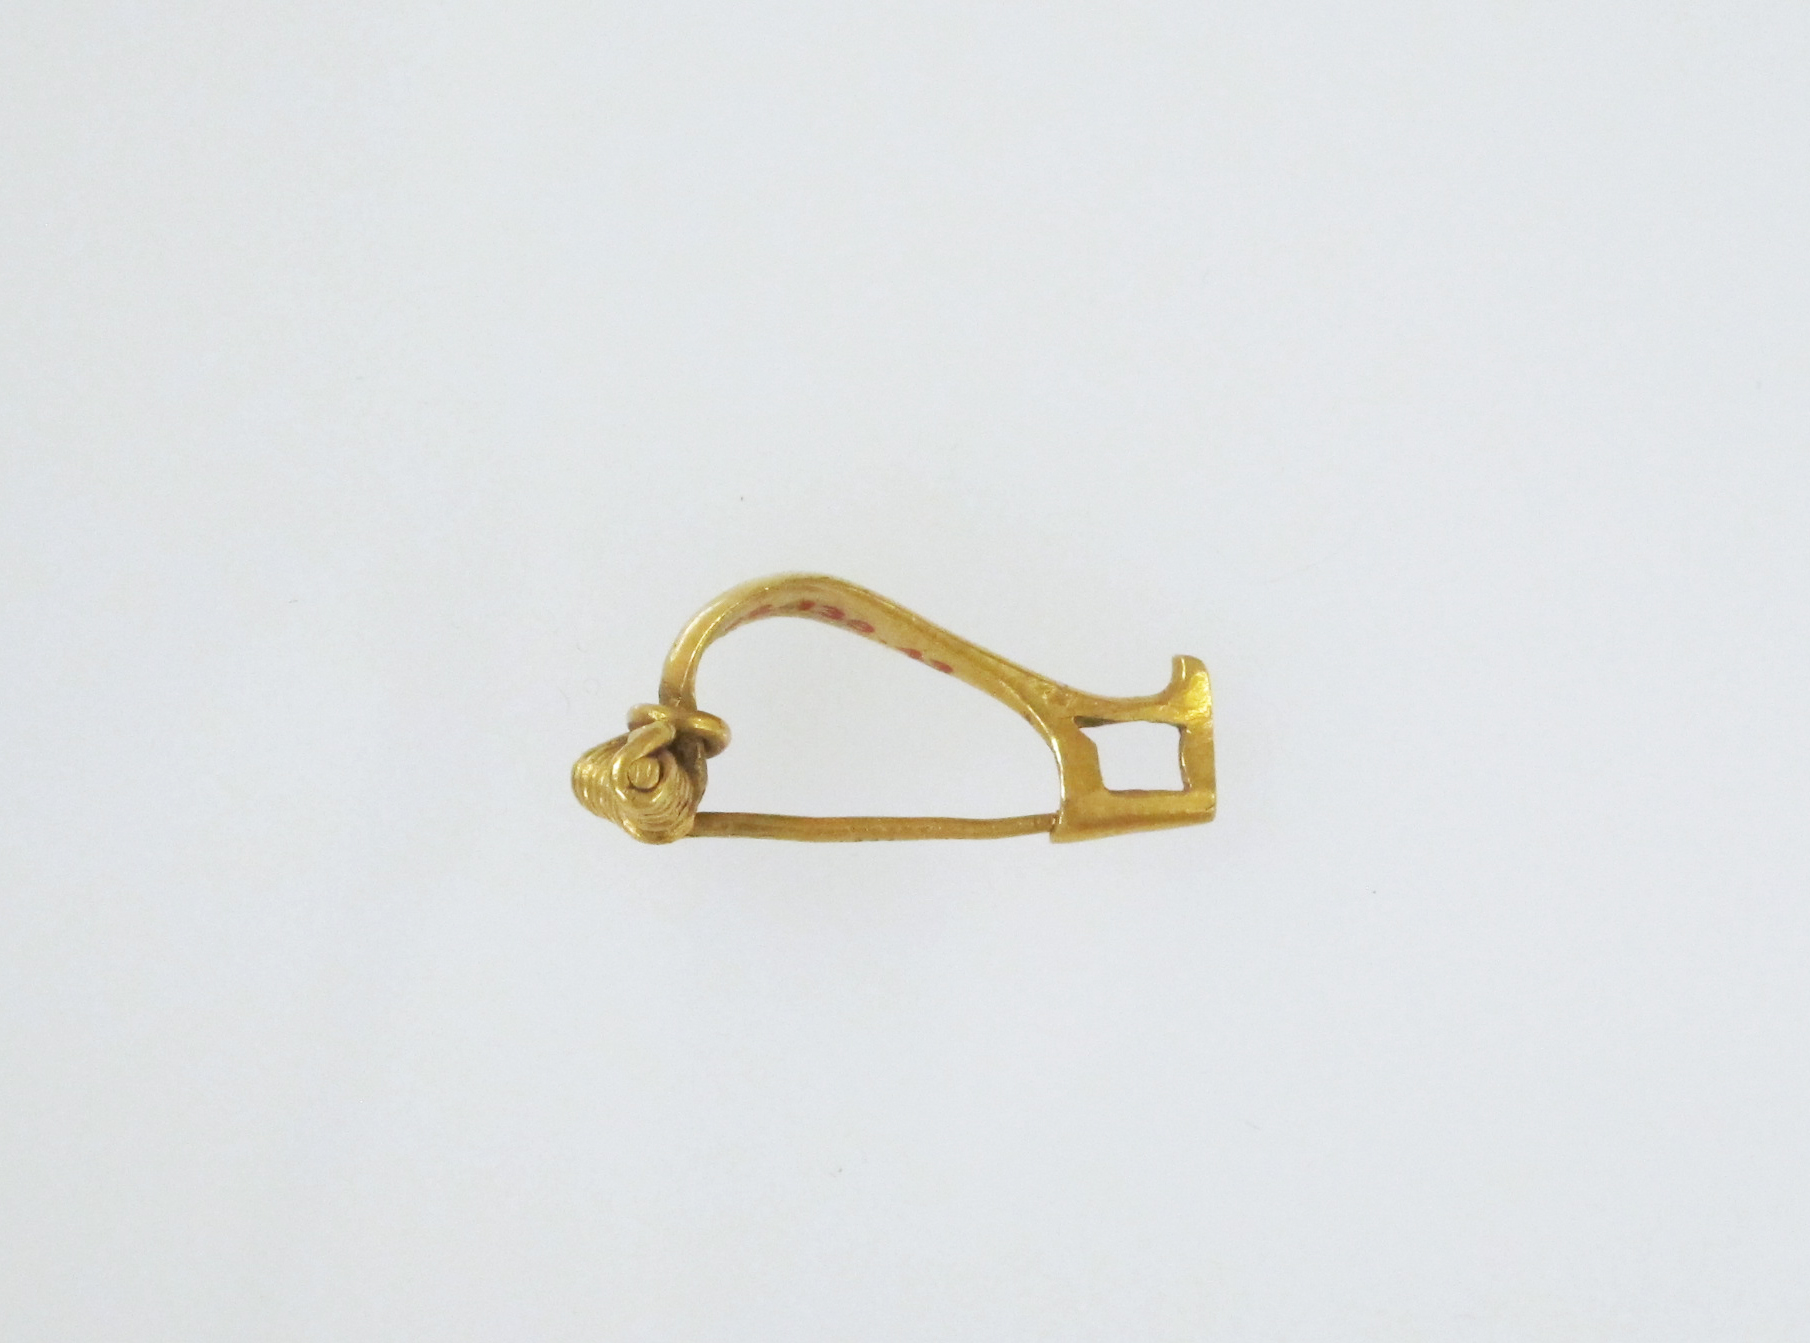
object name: fibula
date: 300-201 BCE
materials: gold